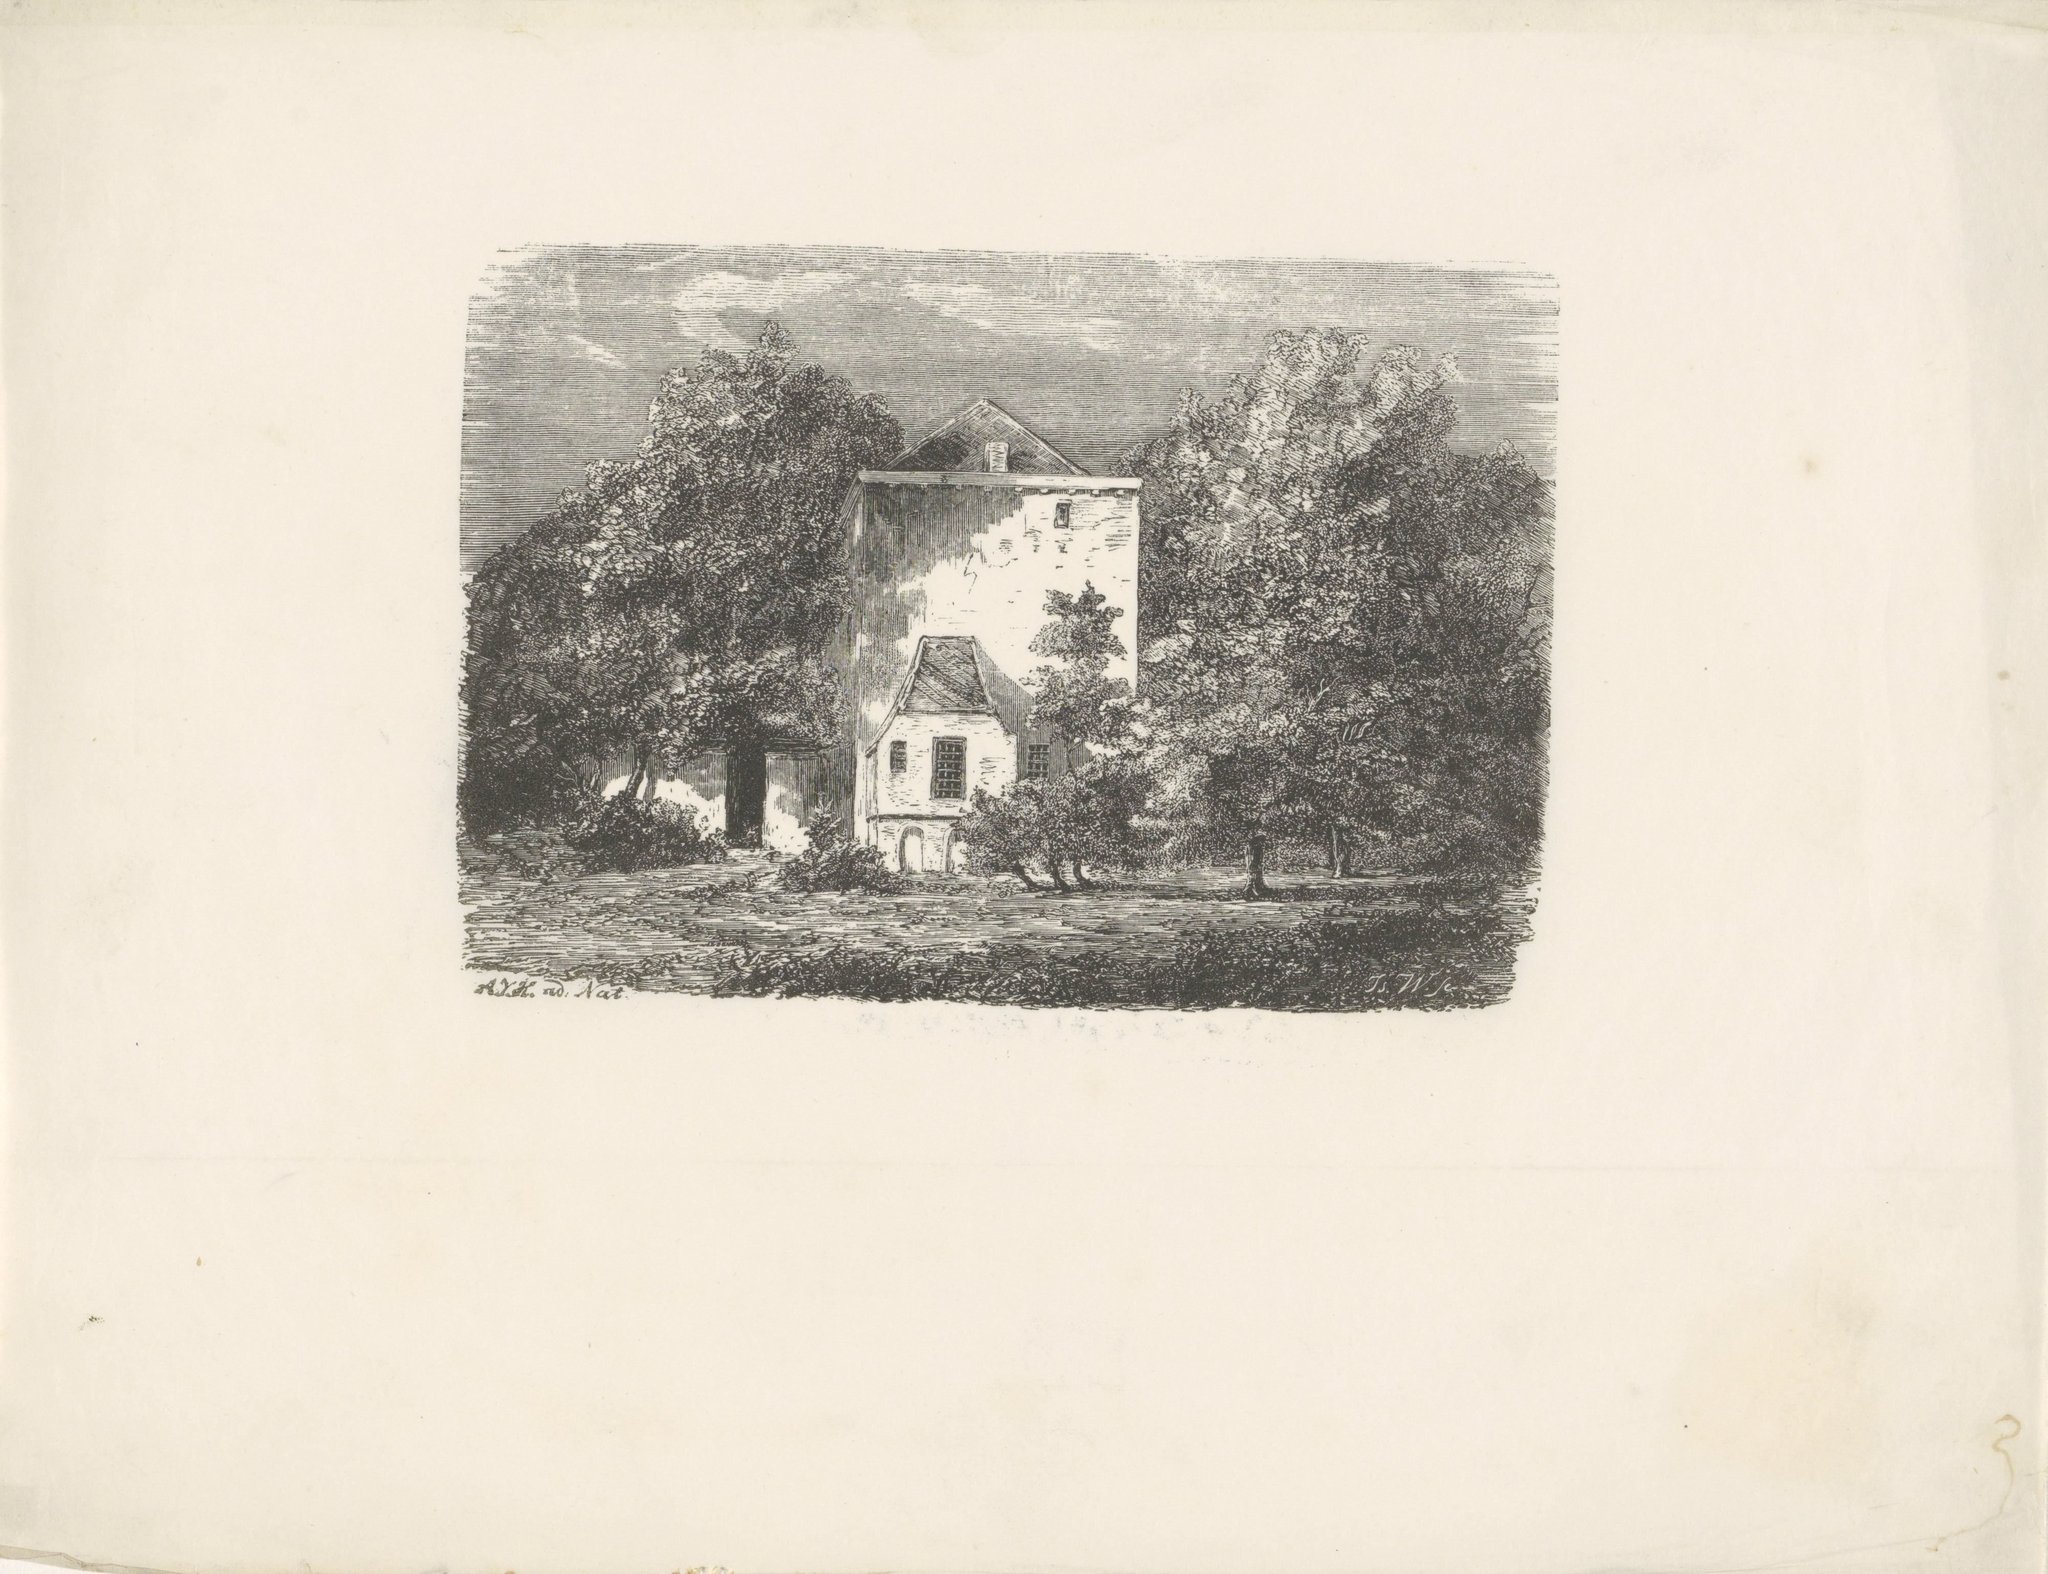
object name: print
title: Gezicht op een bouwwerk te midden van bomen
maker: isaac weissenbruch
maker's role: print maker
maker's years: 1826-1912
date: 1836-1912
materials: paper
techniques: engraving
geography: netherlands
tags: trees, civic architecture; edifices; dwellings